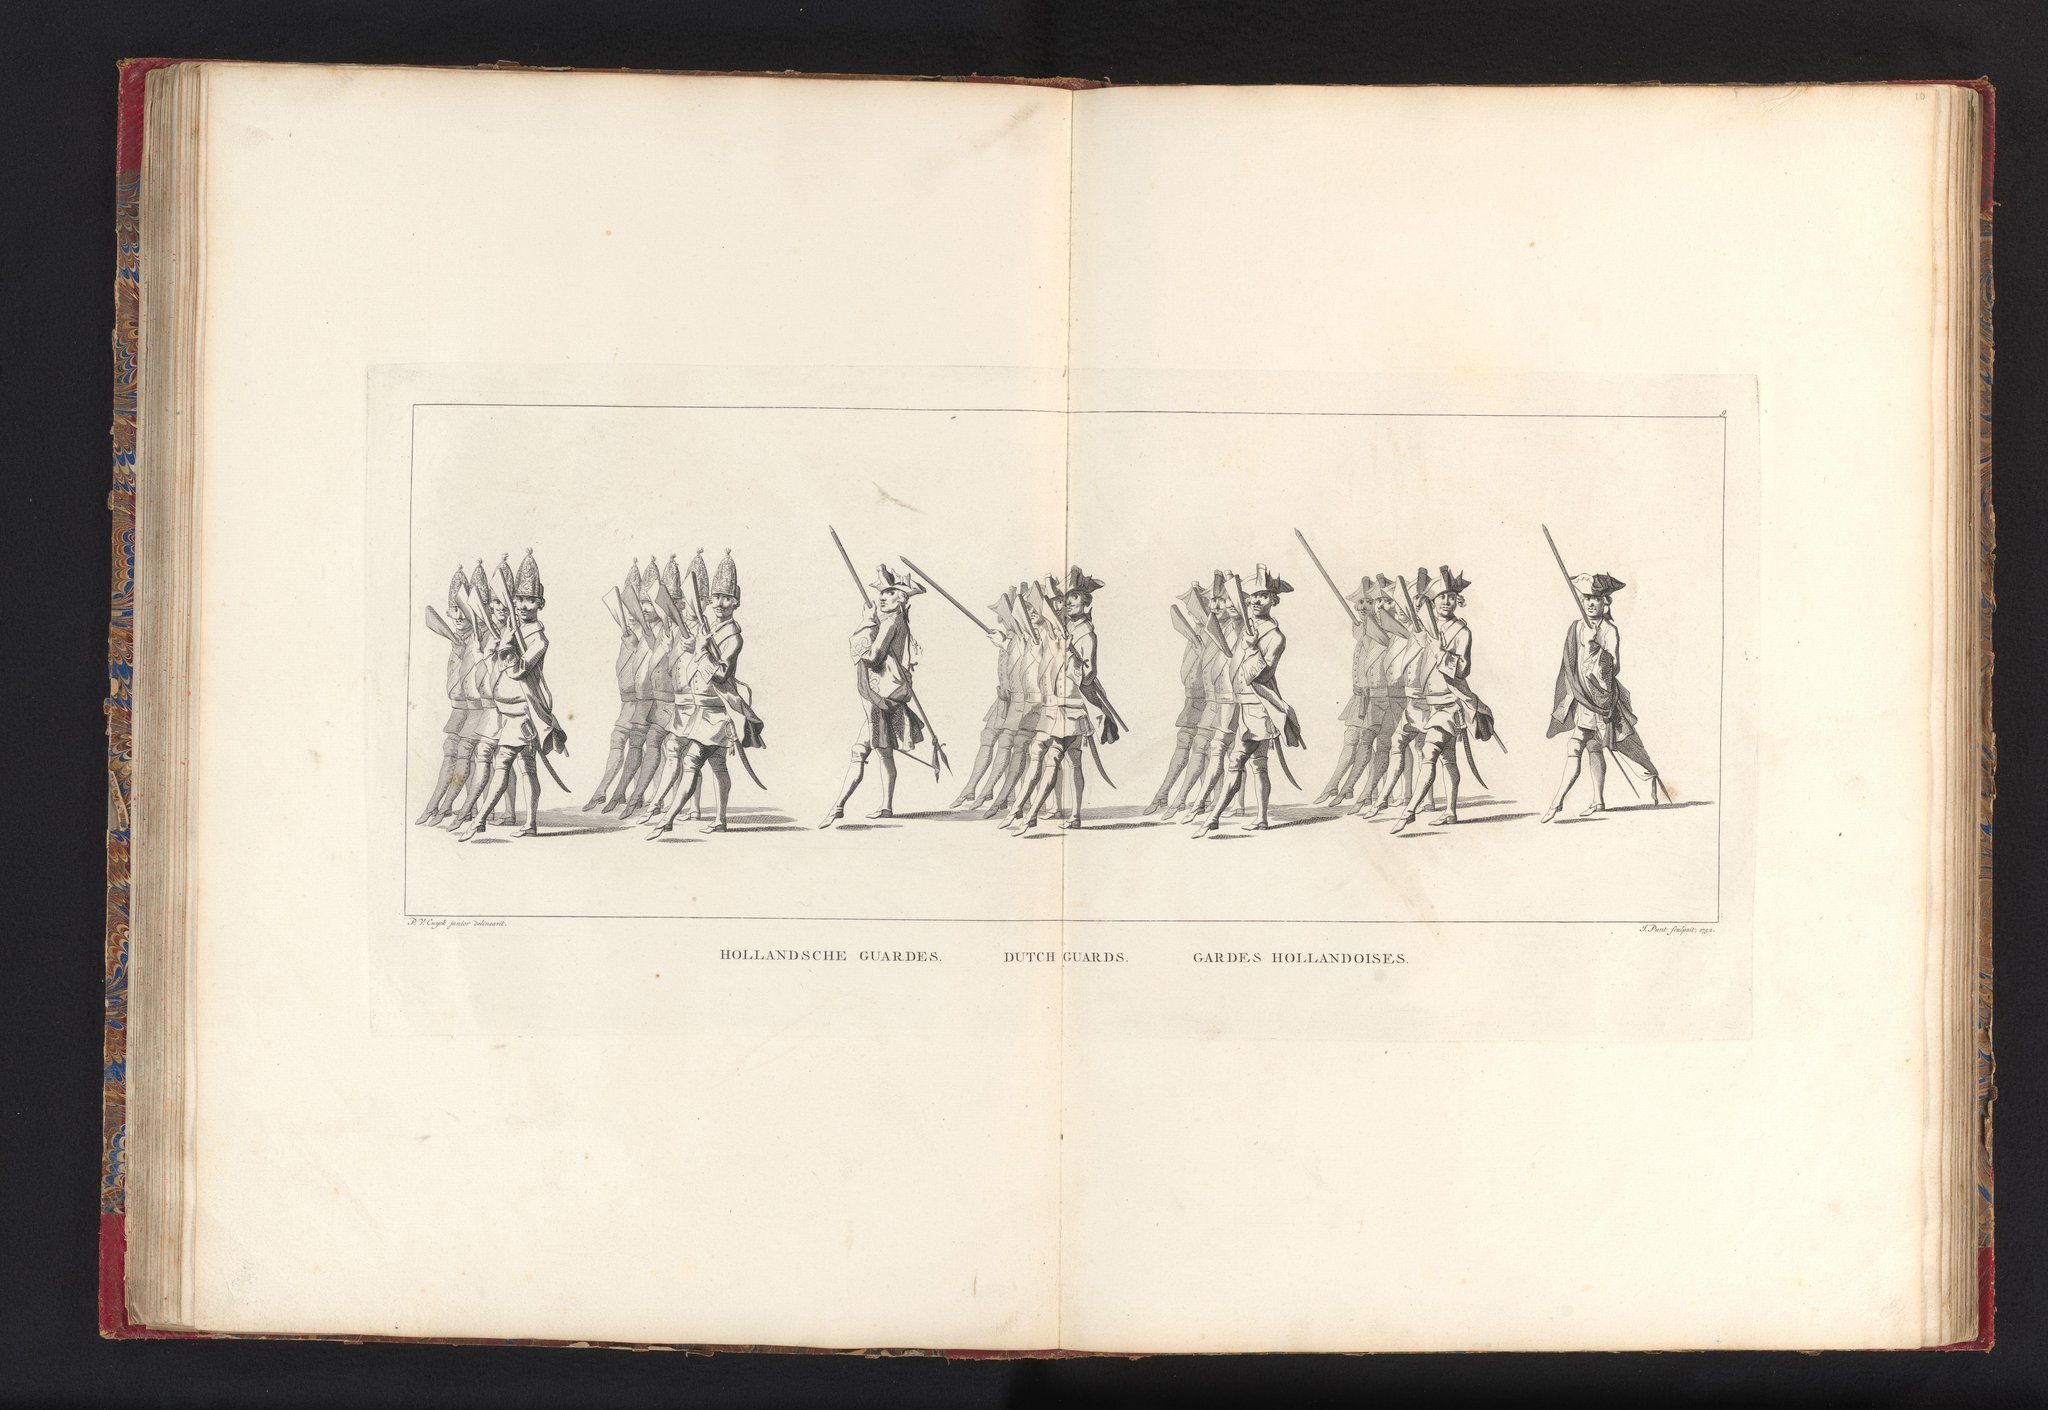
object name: album leaf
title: Lyk-staetsie van zyne doorluchtigste Hoogheid den Heere Willem Carel Hendrik Friso, Prince van Orange en Nassau (...) gehouden den IV Februari 1752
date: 1752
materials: paper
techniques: engraving, etching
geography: the hague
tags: the hague, willem iv (prins van oranje-nassau), military parade, pageant (+ infantry), cortege, funeral procession, delft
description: De Hollandse Garde. In de marge een onderschrift in het Nederlands, Frans en Engels. De prent maakt deel uit van een album.